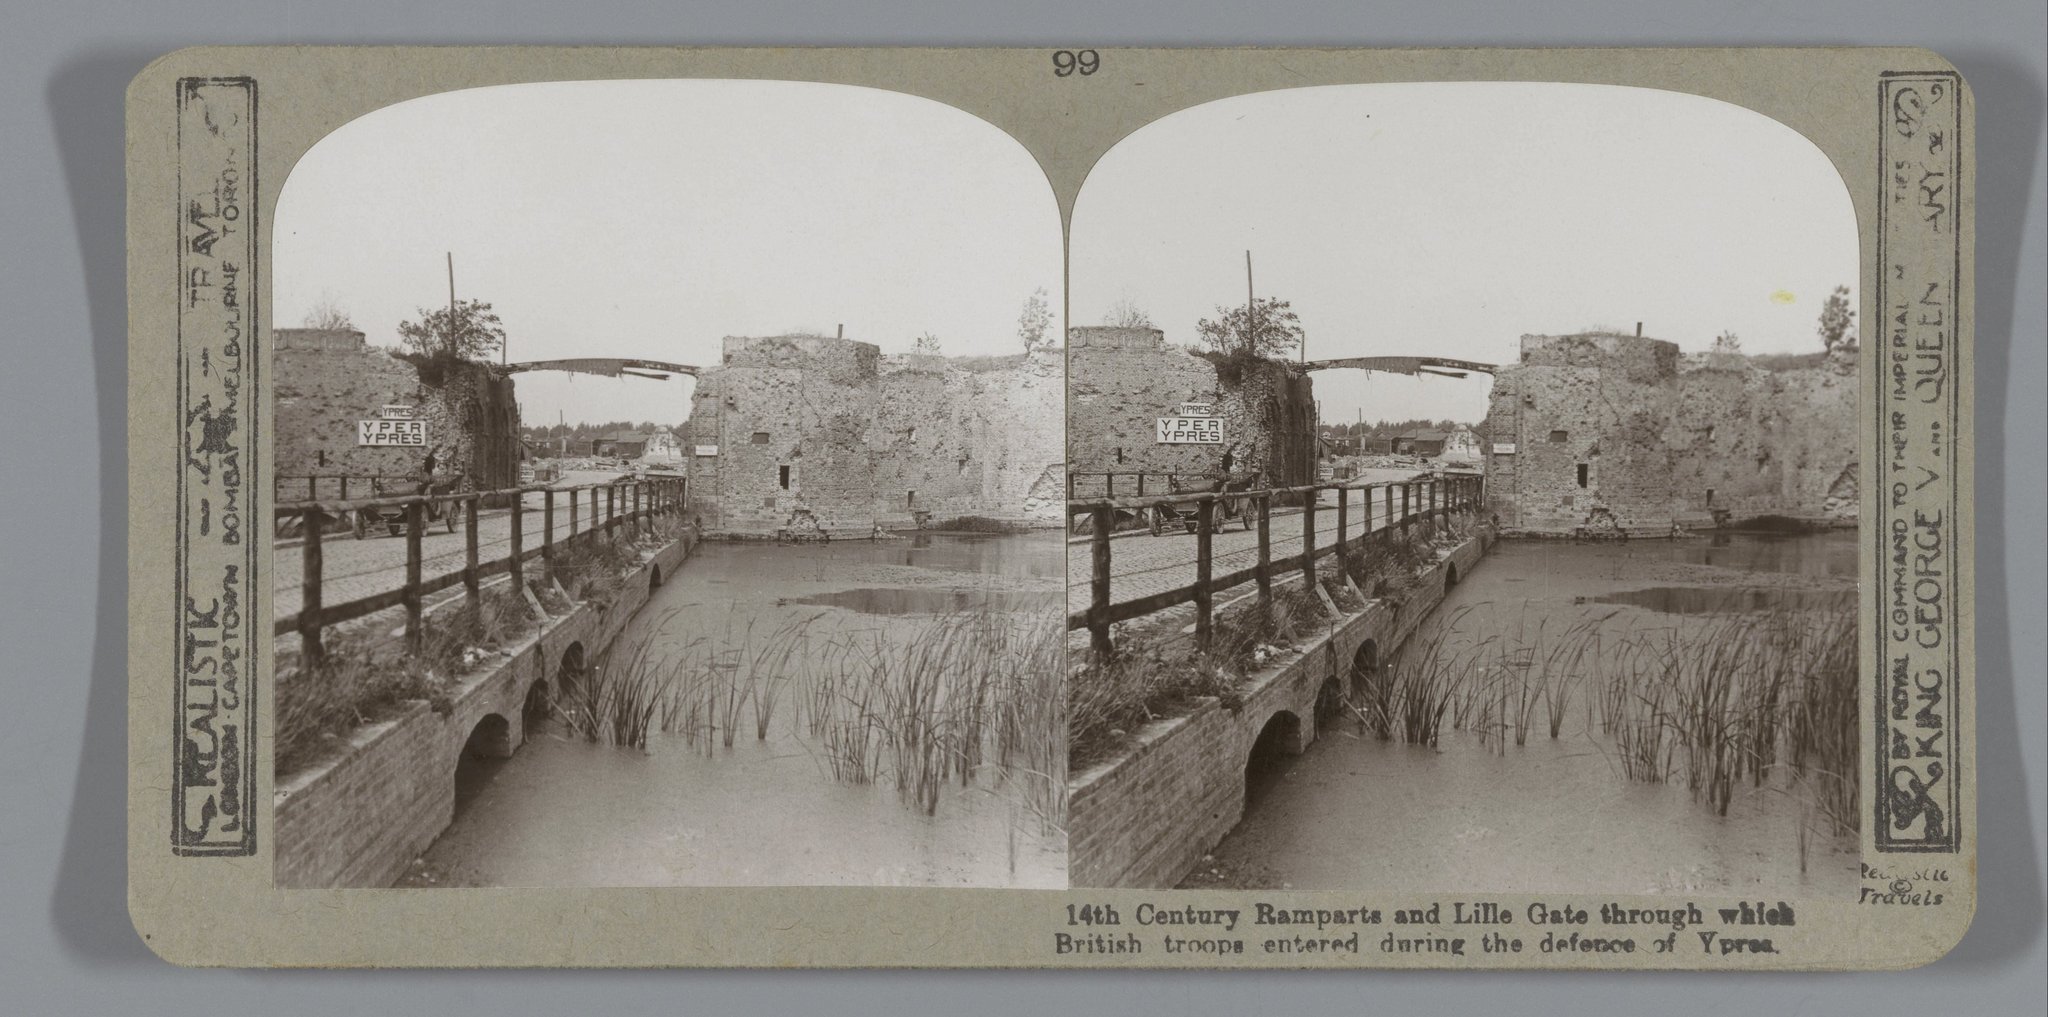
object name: stereograph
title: 14th Century Ramparts and Lilli Gate through which British troops entered during the defence of Ypres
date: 1914-1918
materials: cardboard, photographic support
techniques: gelatin silver print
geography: ieper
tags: city-walls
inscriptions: number: ‘99’, inscription: ‘By Royal command to their Imperial majesties King George V and Queen Mary’